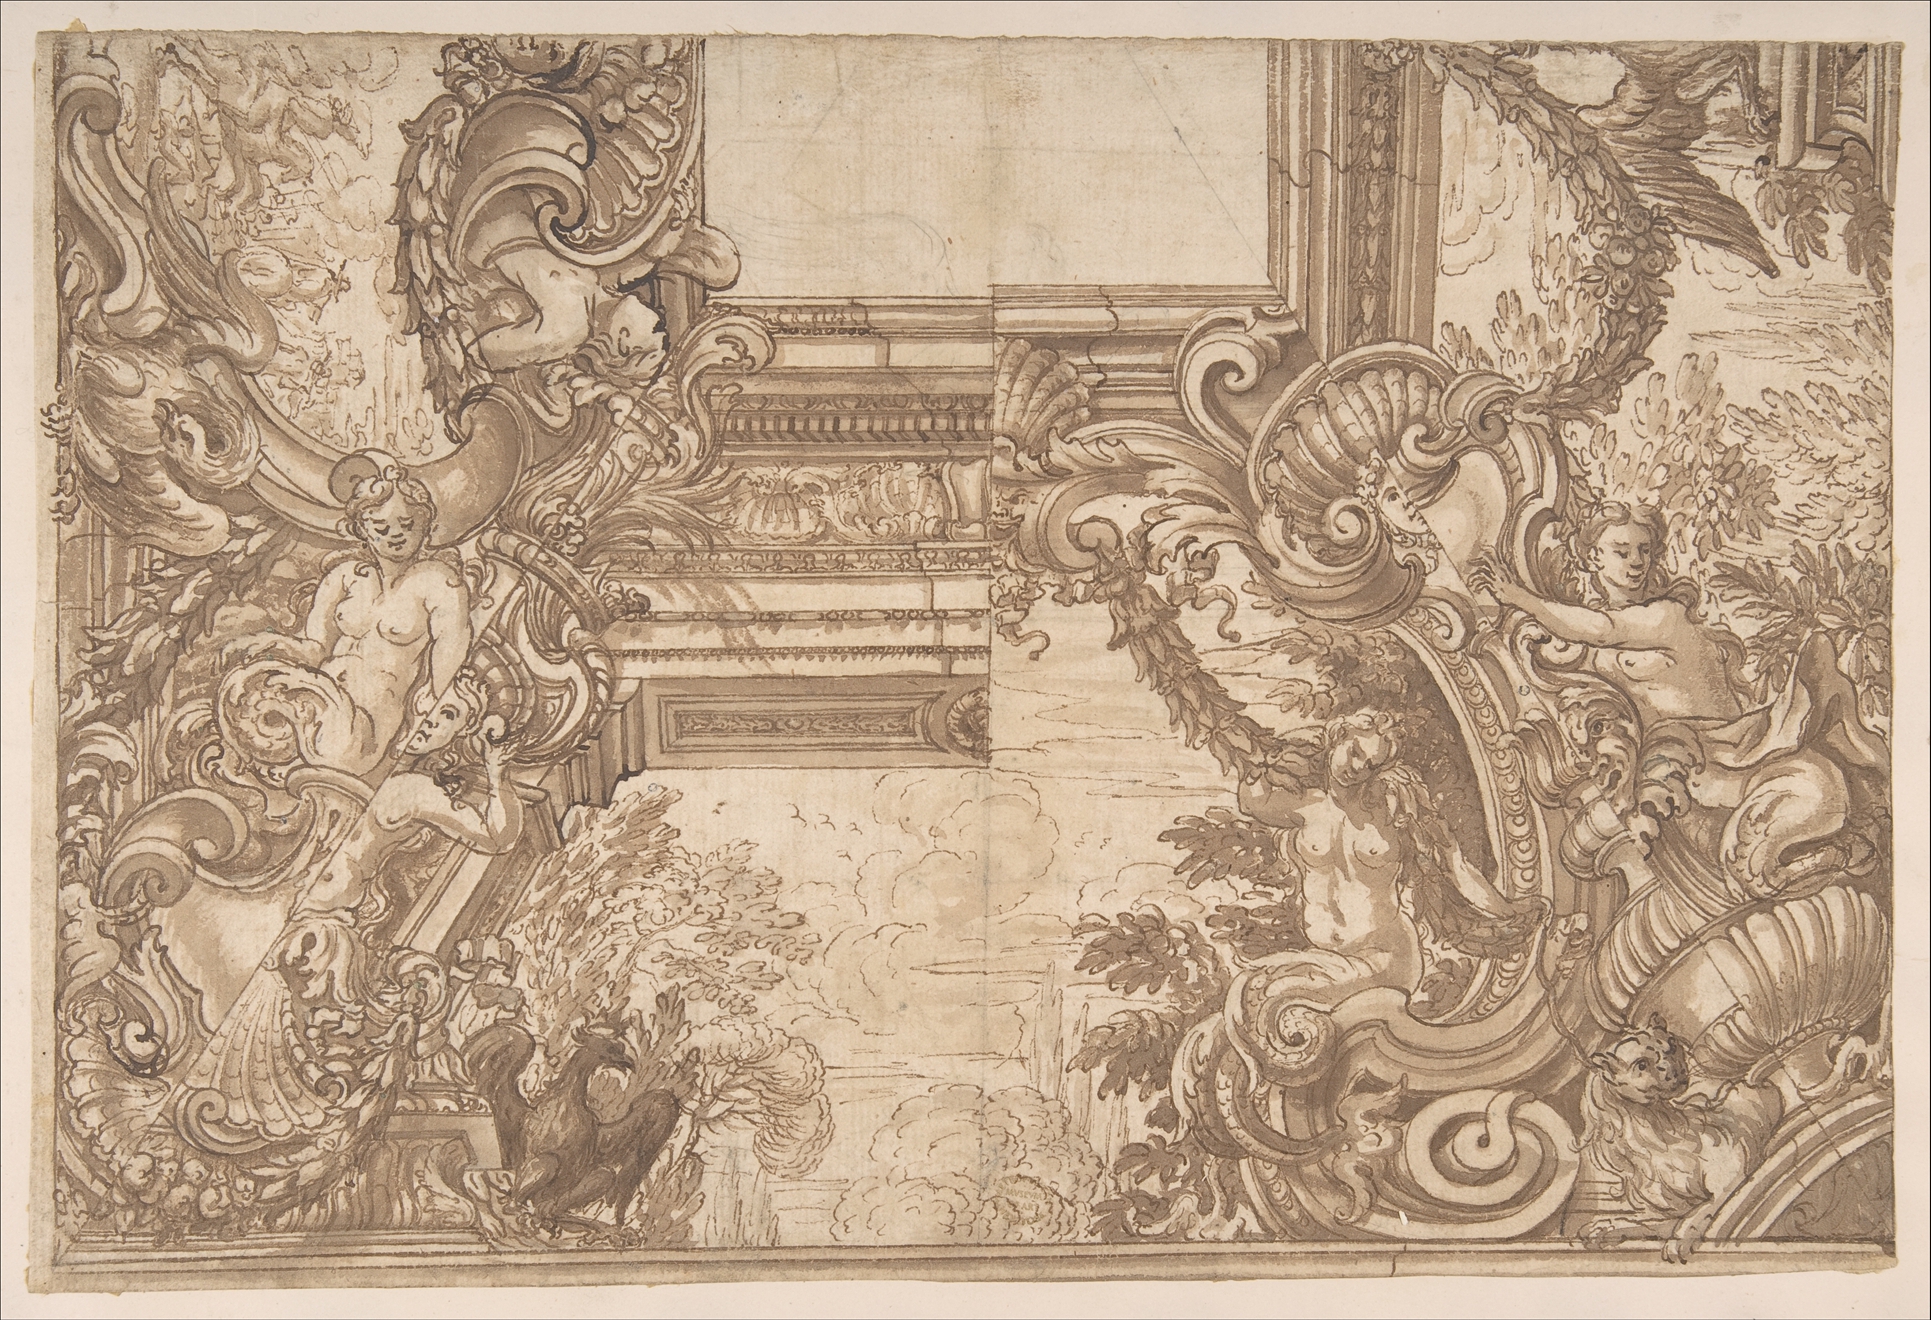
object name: drawing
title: Alternate Designs for a Cove Decoration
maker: anonymous, italian, roman-bolognese, 17th century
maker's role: artist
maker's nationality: italian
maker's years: 1600-1700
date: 1601-1700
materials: chalk, ink, paper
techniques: brush, pen, wash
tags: eagles,female nudes